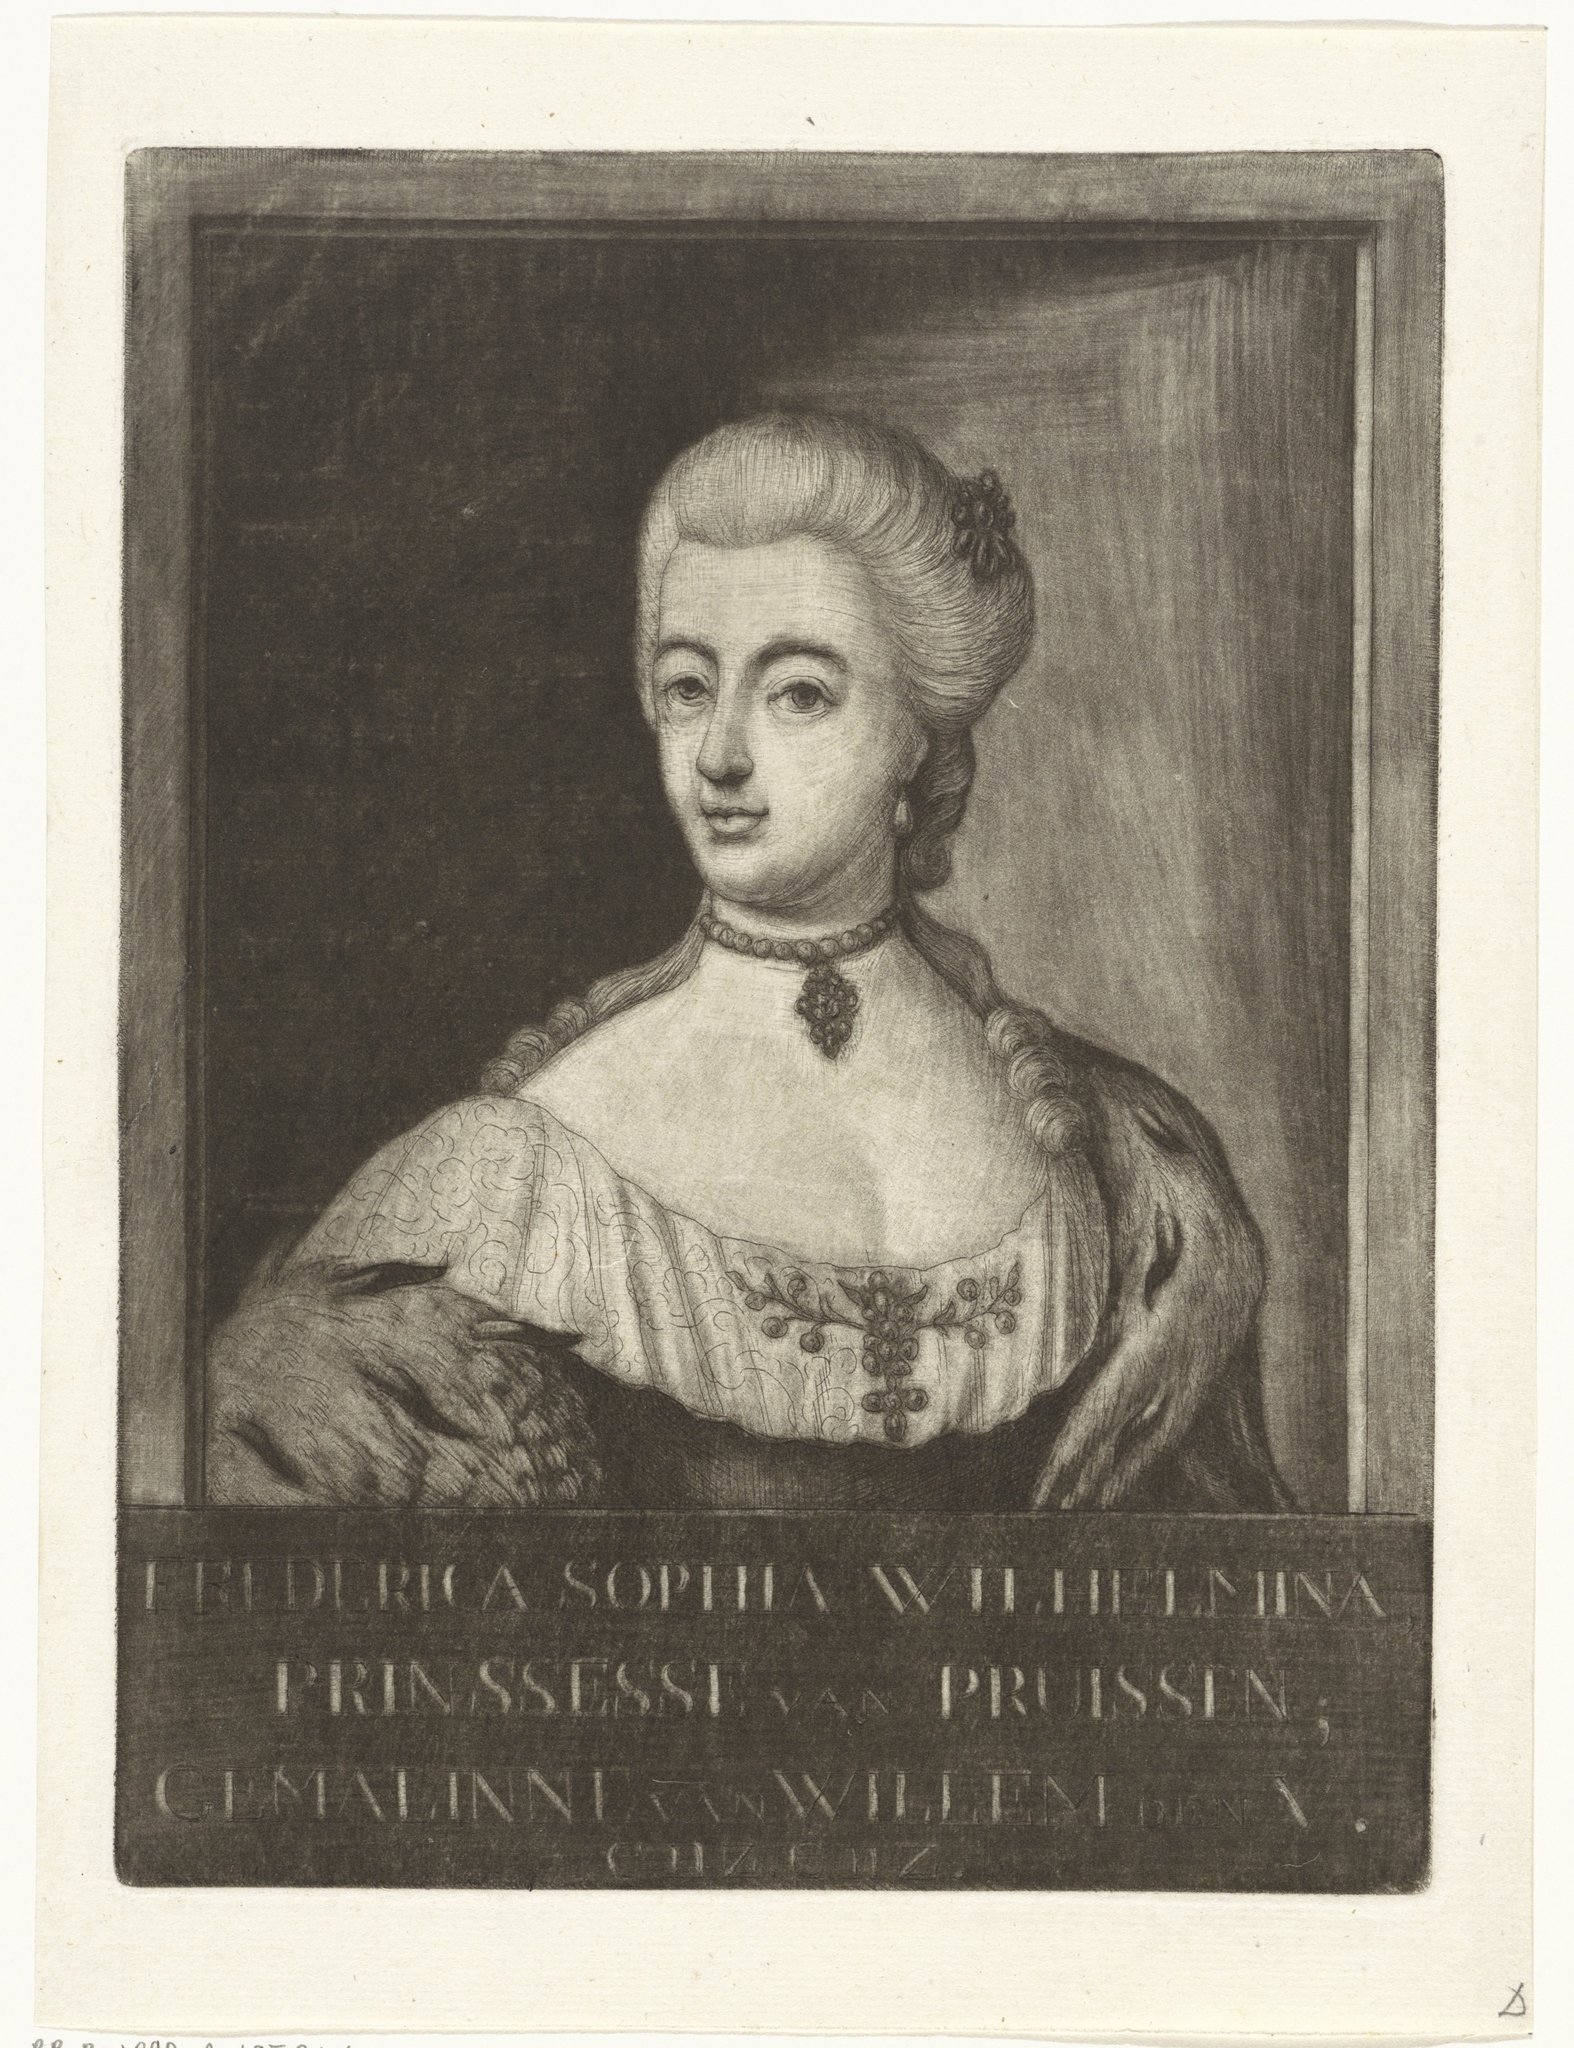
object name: print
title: Portret van Wilhelmina van Pruisen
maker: rienk jelgerhuis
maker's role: draughtsman, print maker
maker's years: 1729-1806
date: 1770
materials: paper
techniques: etching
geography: leeuwarden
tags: berlin, painter, draughtsman, wilhelmina of prussia (princess of orange)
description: Ook gebruikt als illustratie in: Bosch, Johannes van den. De heeren stadhouderen van Vriesland, zedert den jare acht-hondert. Leeuwarden: Abraham Ferwerda en G.Tresling, 1770.